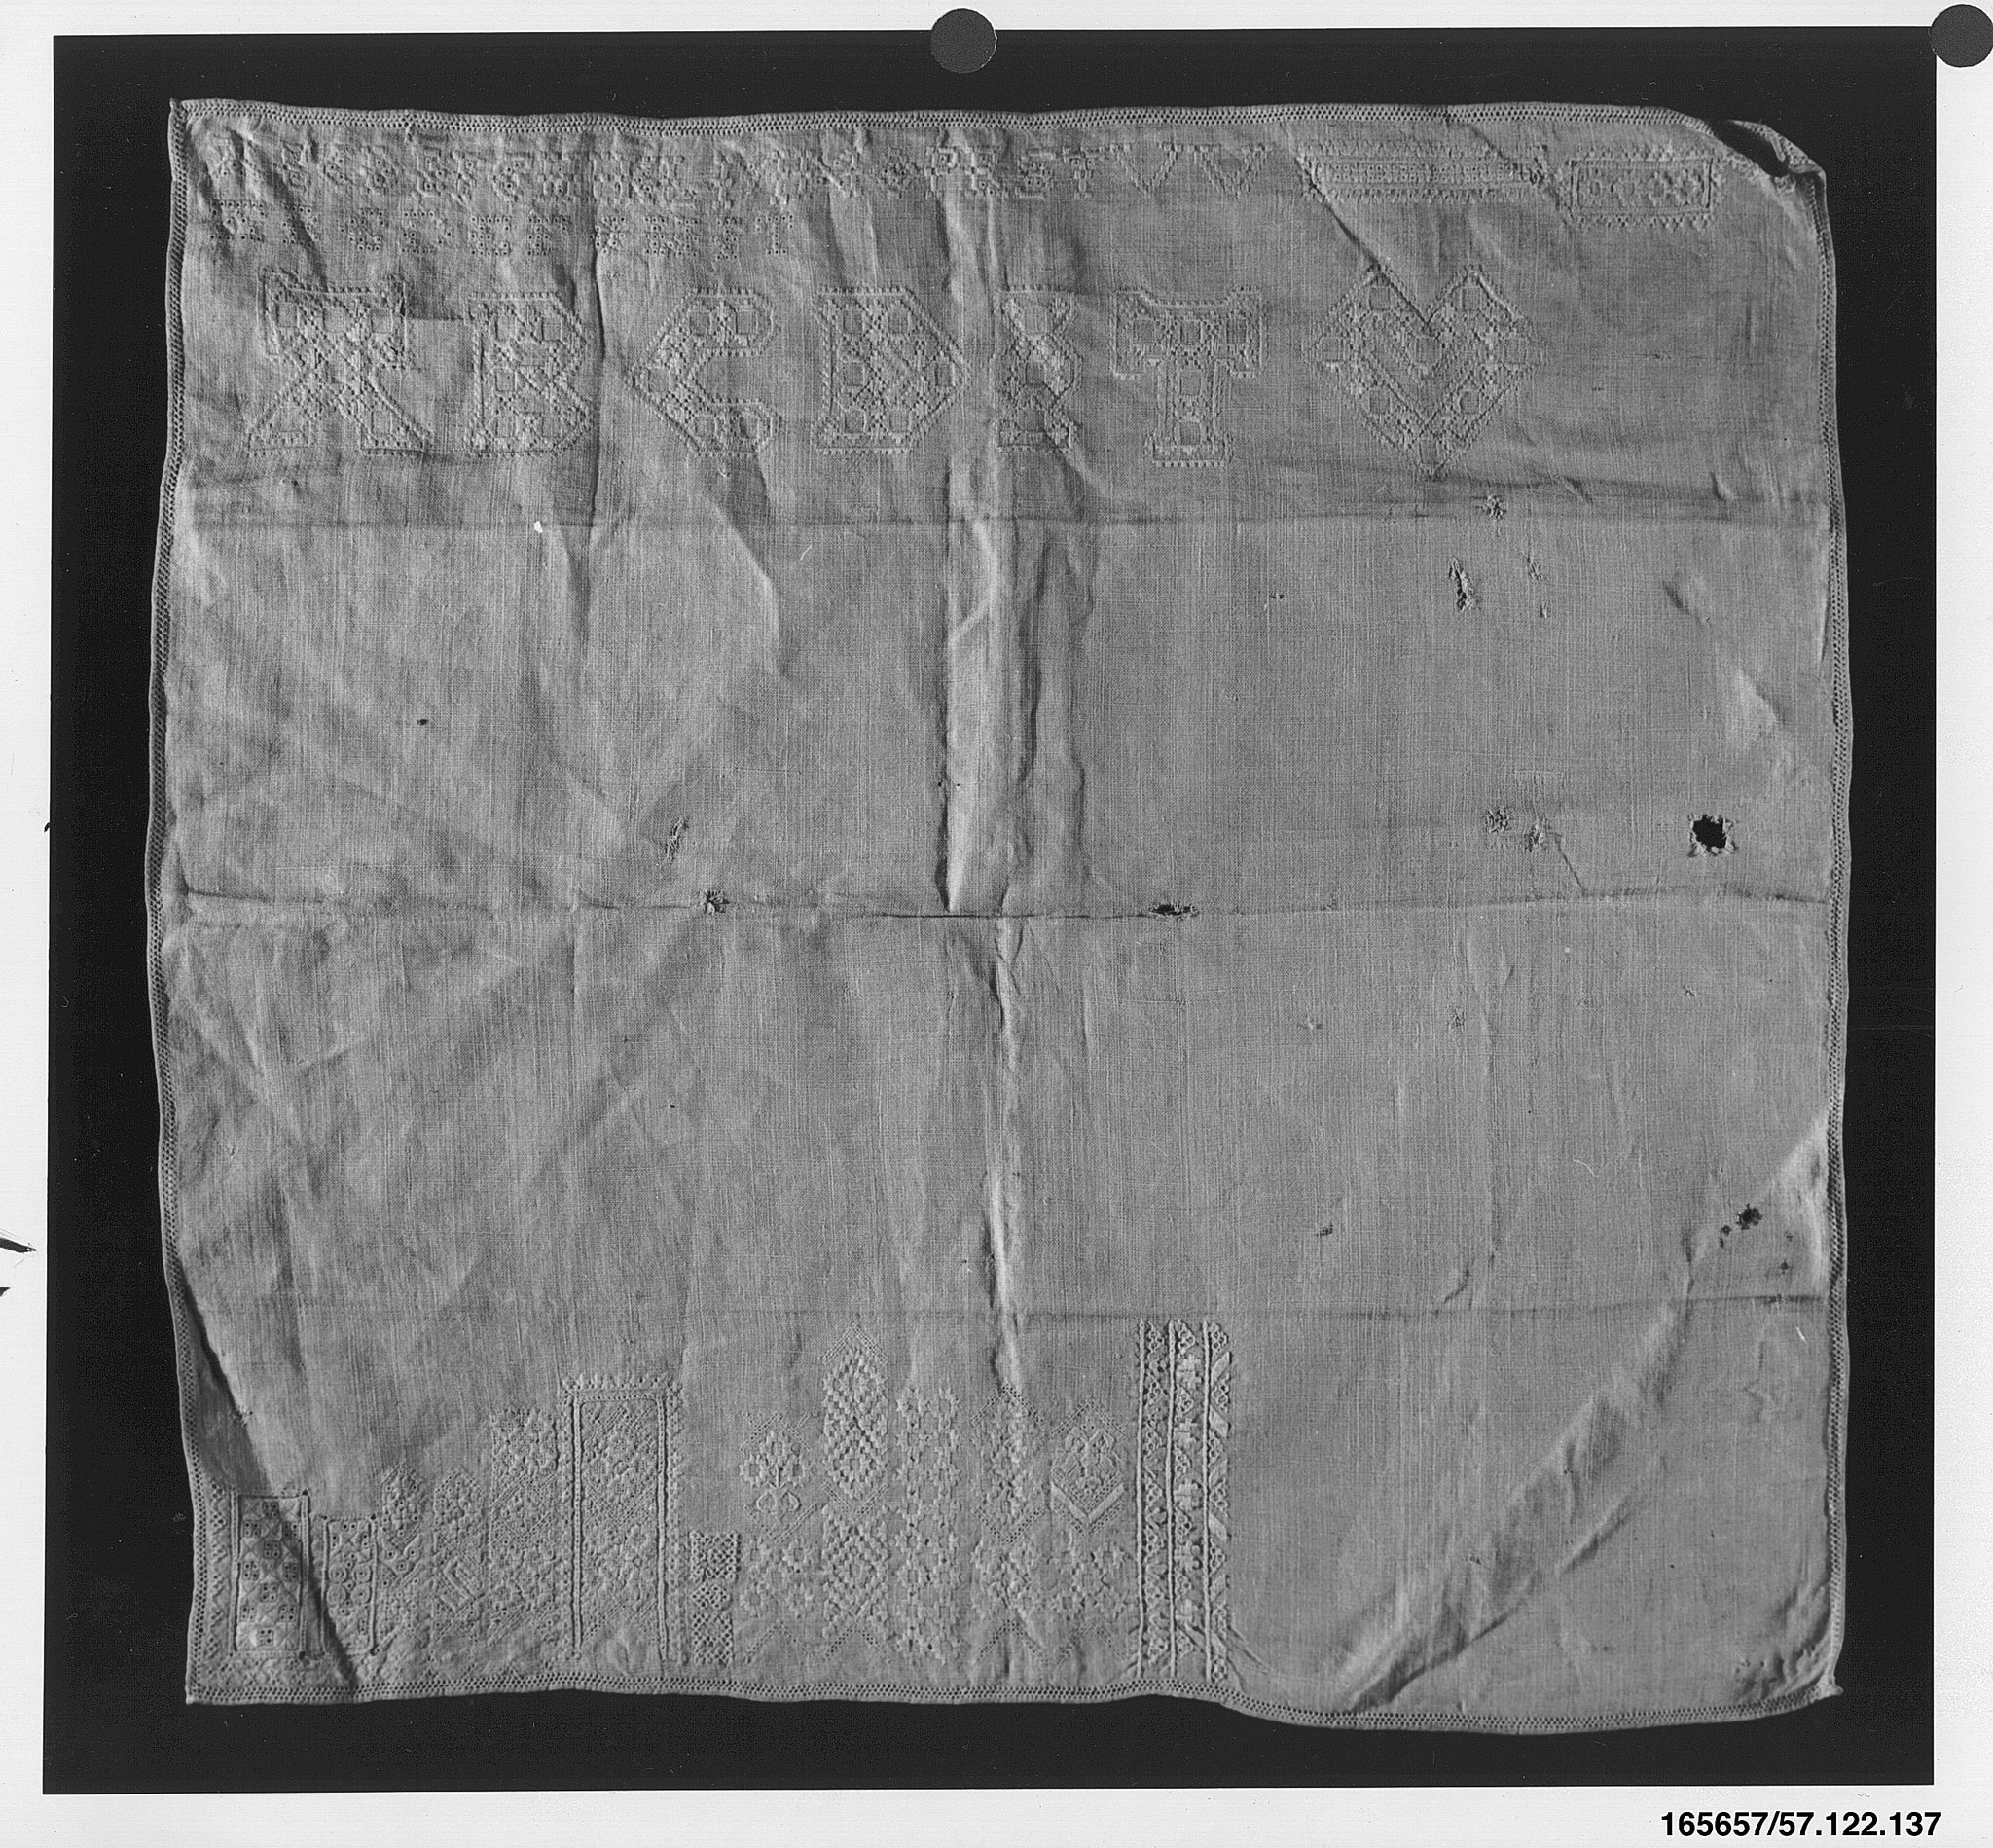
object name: sampler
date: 1701-1800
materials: linen